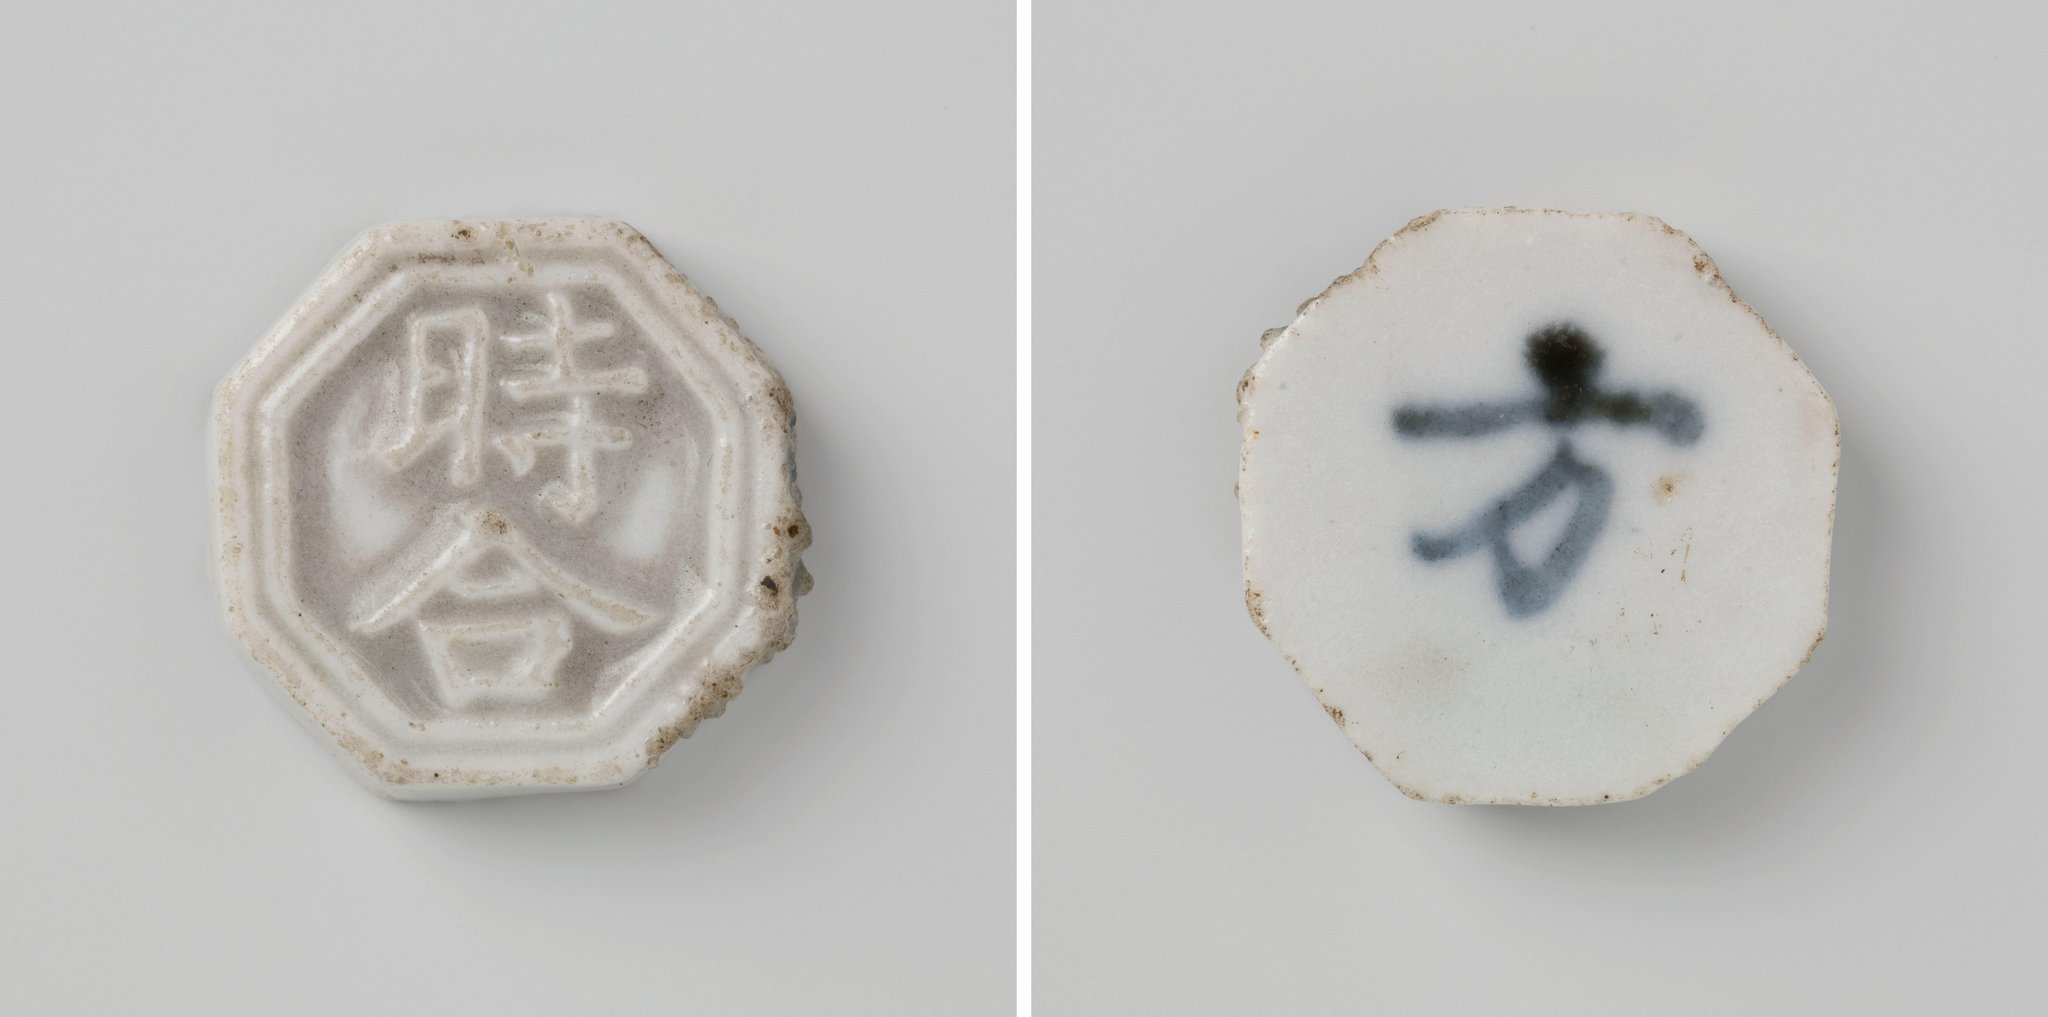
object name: coin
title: Speelhuispenning uit Thailand ter waarde van een fuang, 1760-1871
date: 1760-1871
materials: porcelain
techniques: firing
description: Achthoekige porseleinen speelhuispenning, die ook als munt is gebruikt. Voorzijde: twee Chinese karakters. Keerzijde: een Chinees karakter.